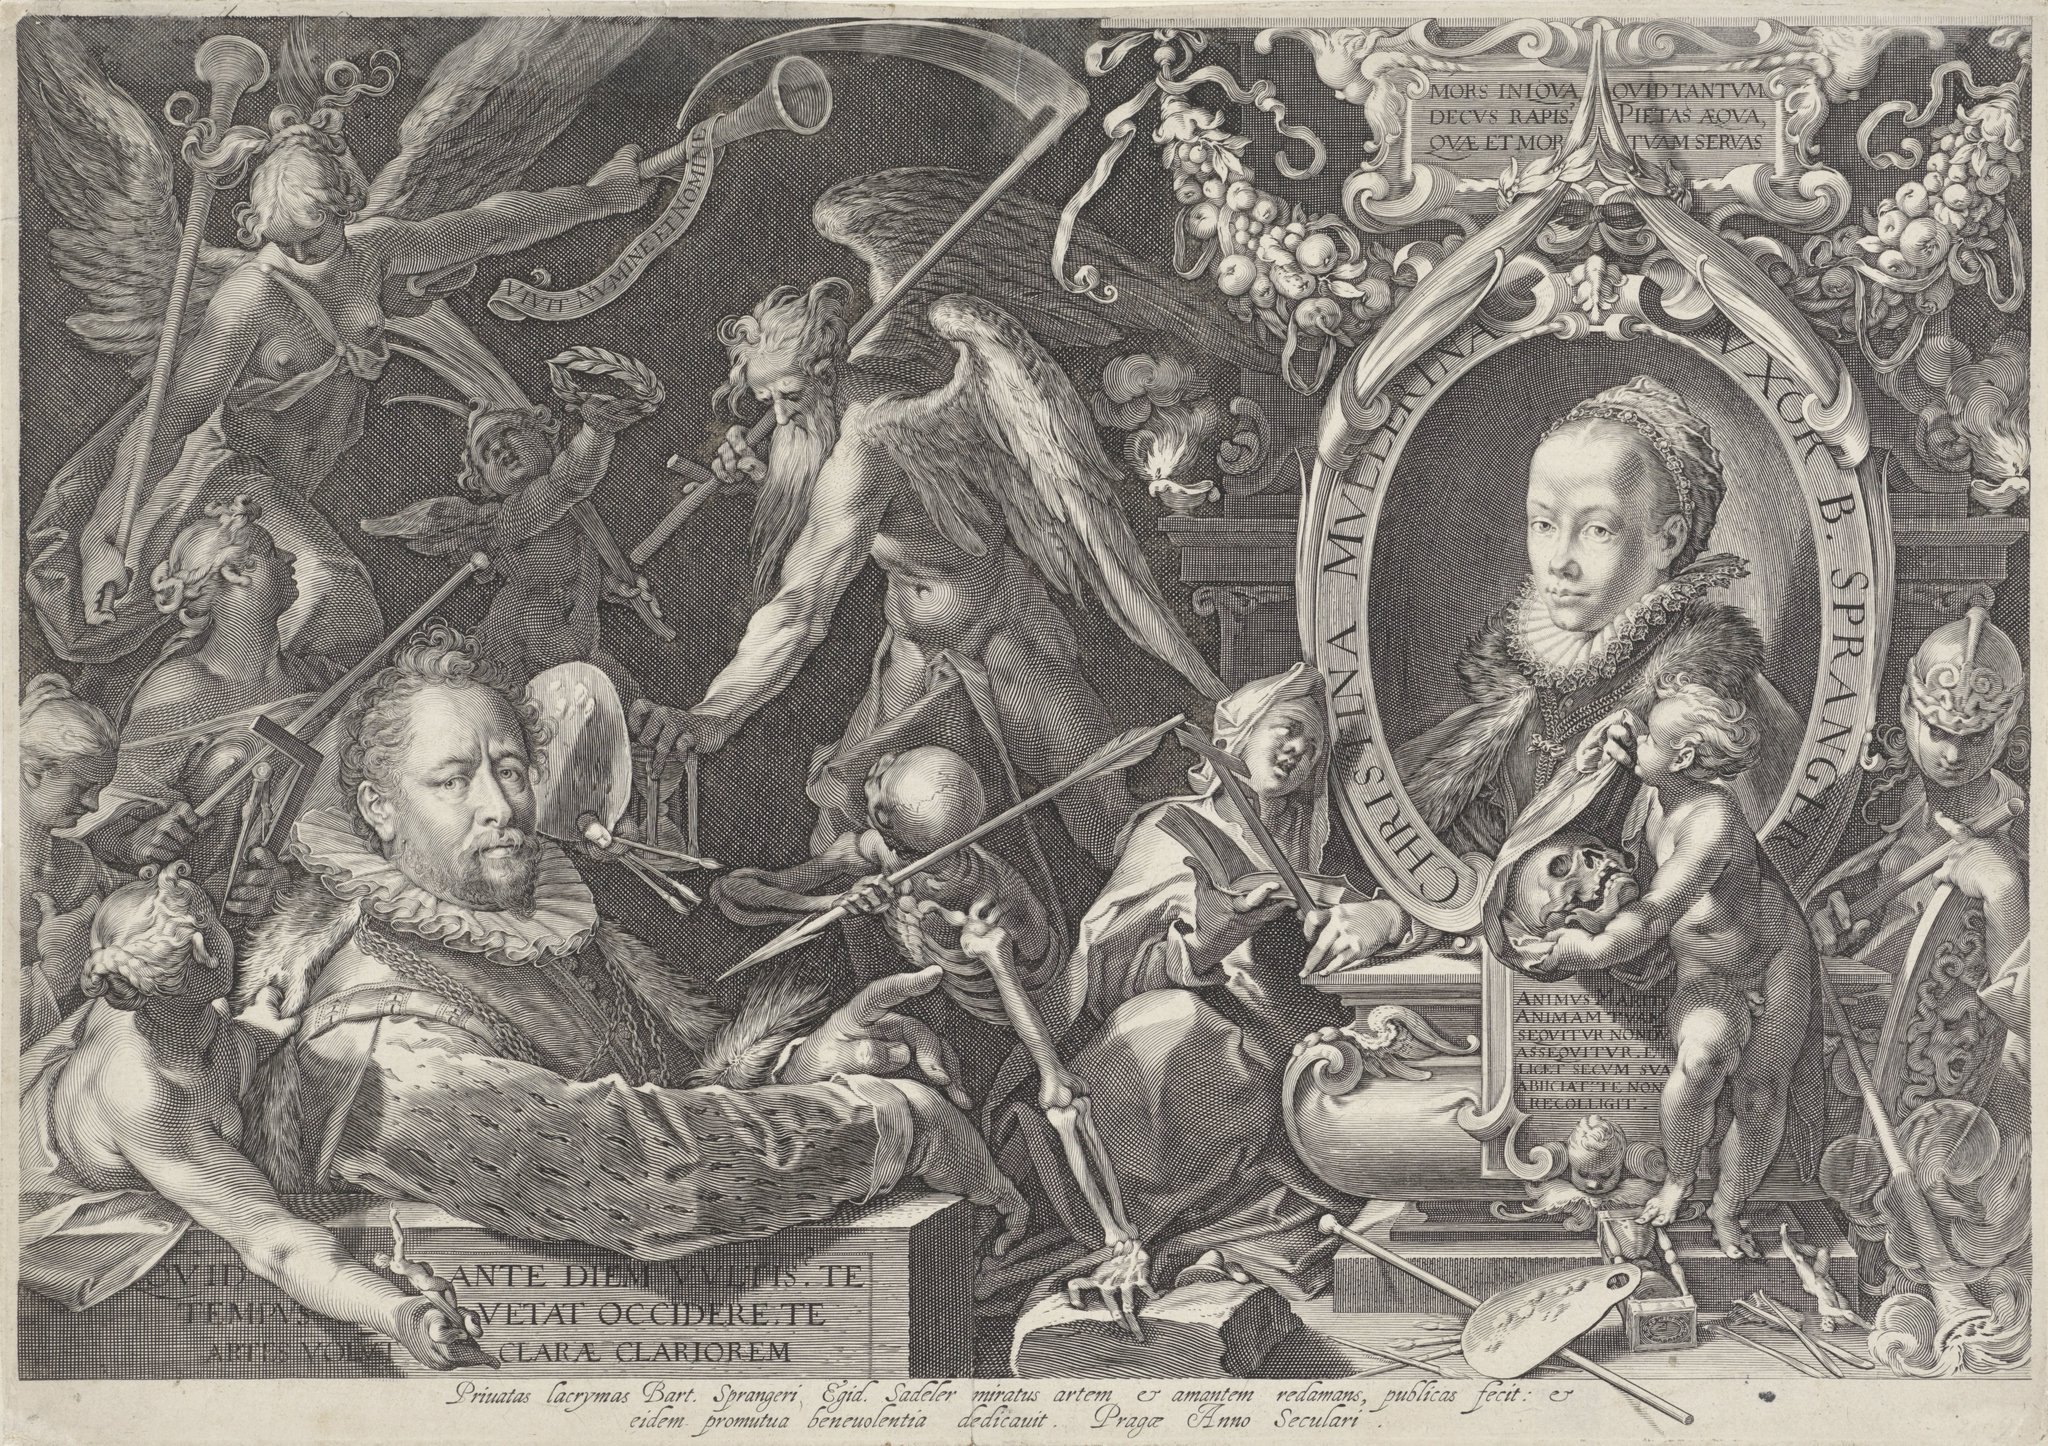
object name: print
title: Allegorisch portret van Bartholomeus Spranger en zijn vrouw Christina Muller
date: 1600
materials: paper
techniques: engraving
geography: prague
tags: antwerp, prague, painter, print maker, bartholomeus spranger, faith, 'fides'; 'fede', 'fede catholica', 'fede christiana', 'fede christiana catholica' (ripa) ~ one of the three theological virtues, (story of) minerva (pallas, athena), death as skeleton, tools, implements of painter, person(s) sitting among objects forming a 'vanitas' still life, fame; 'fama', 'fama buona', 'fama chiara' (ripa), ornament ~ festoon, garland, father time, man with wings and scythe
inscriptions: collector's mark: Lugt 2228, collector's mark: Lugt 2760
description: Gedenkprent voor de overleden vrouw van de schilder Batholomeus Spranger. Links Bartholomeus Spranger en rechts zijn vrouw Christina Muller. De twee portretten worden omringd door de personificaties van de vrije kunsten, het geloof, de tijd, de dood en de roem.